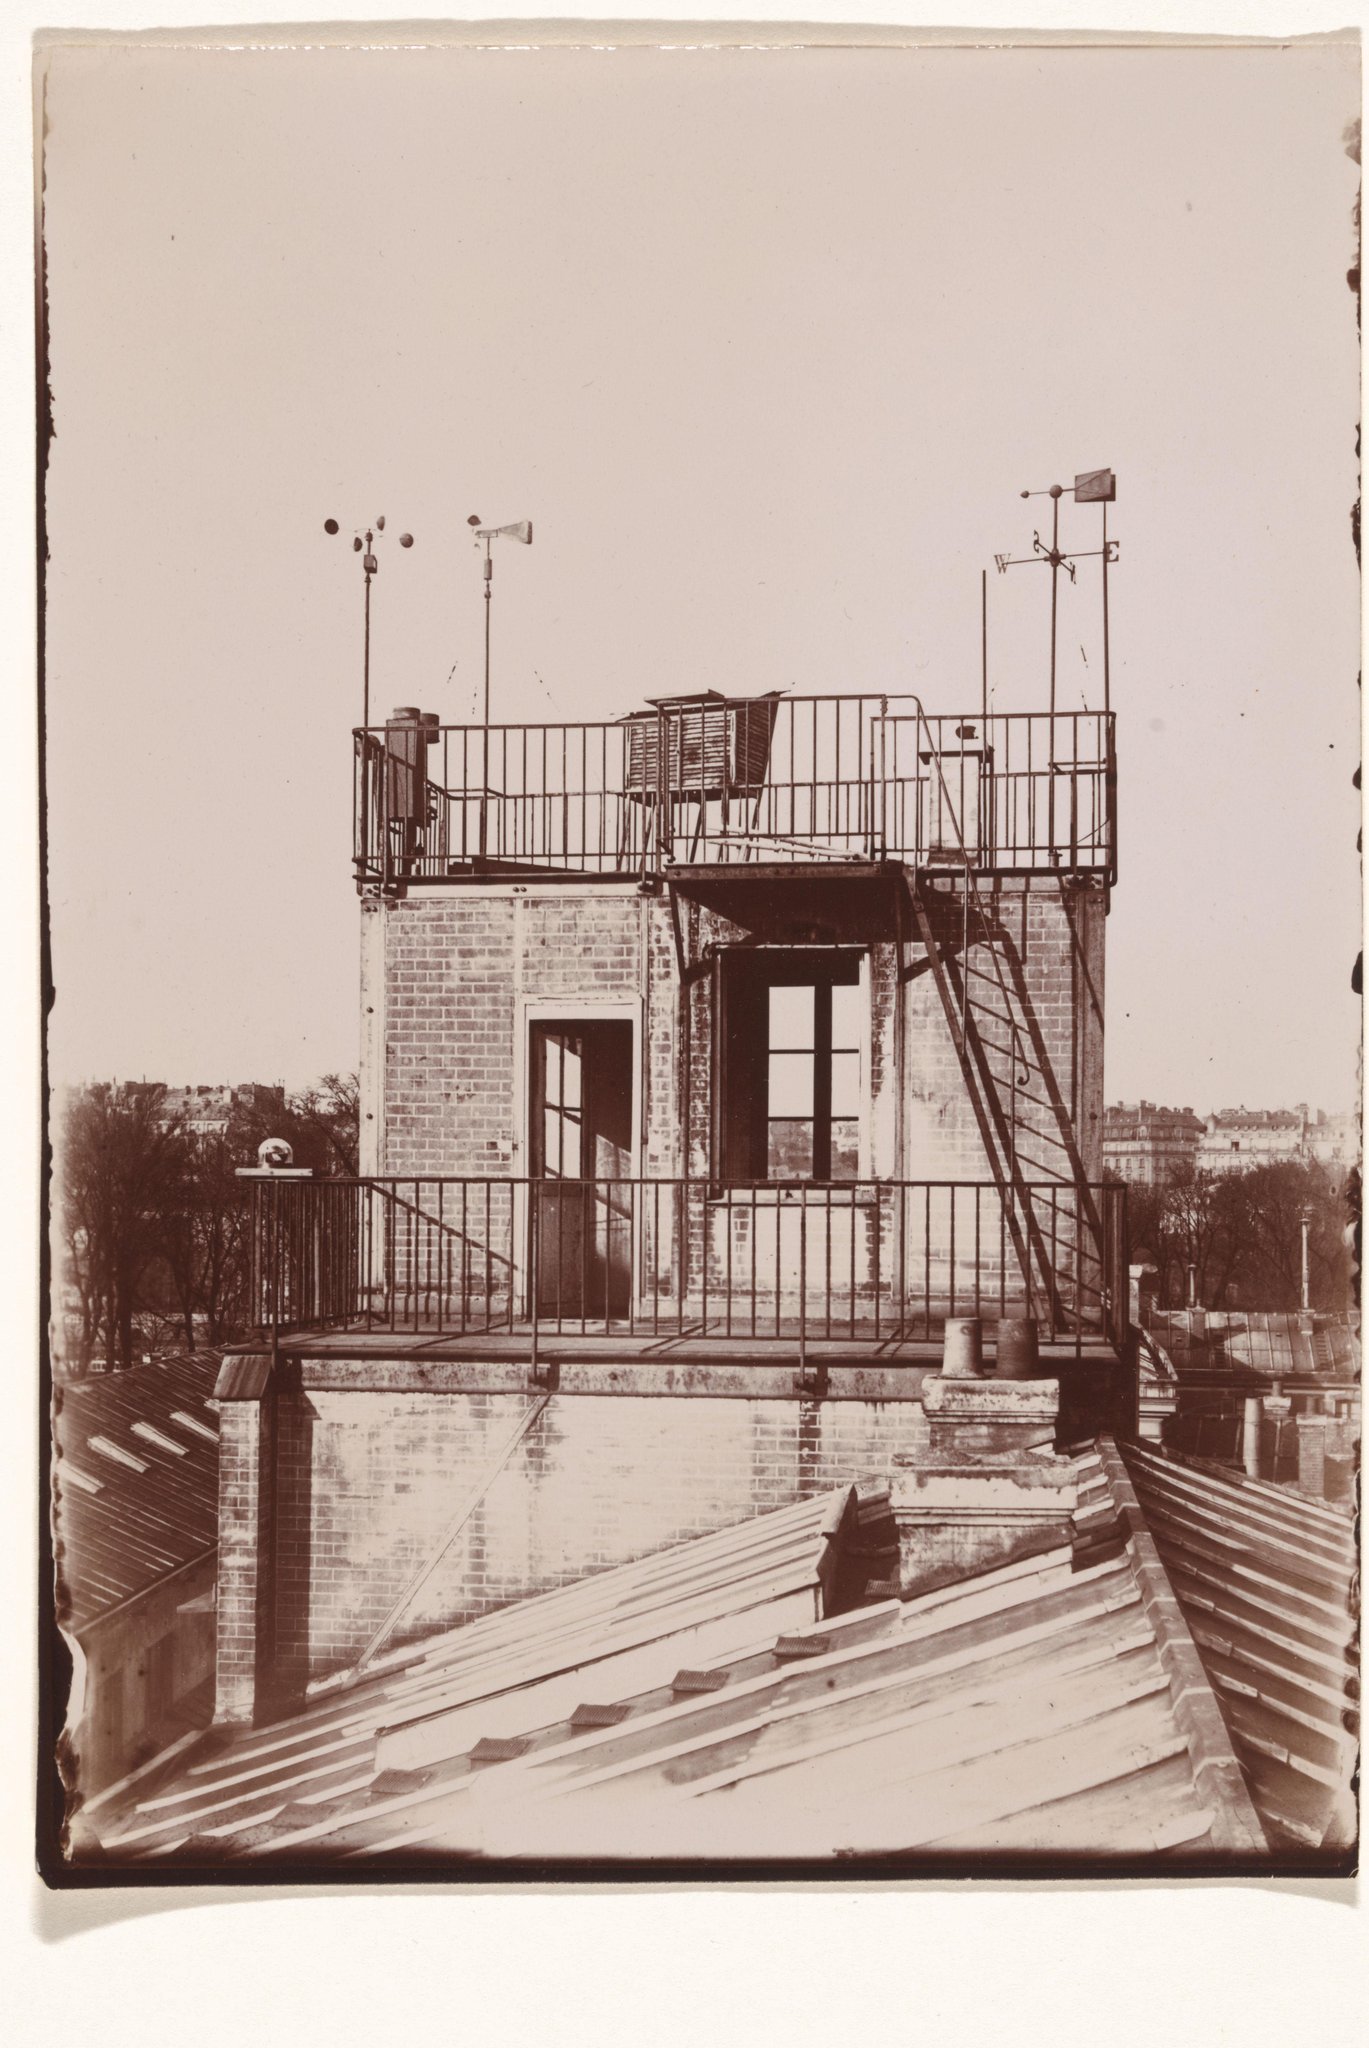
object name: photograph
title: Weerstation op een dak, Parijs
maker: Anonymous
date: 1900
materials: paper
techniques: gelatin silver print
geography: paris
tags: roof (of house or building), meteorological observatory, paris